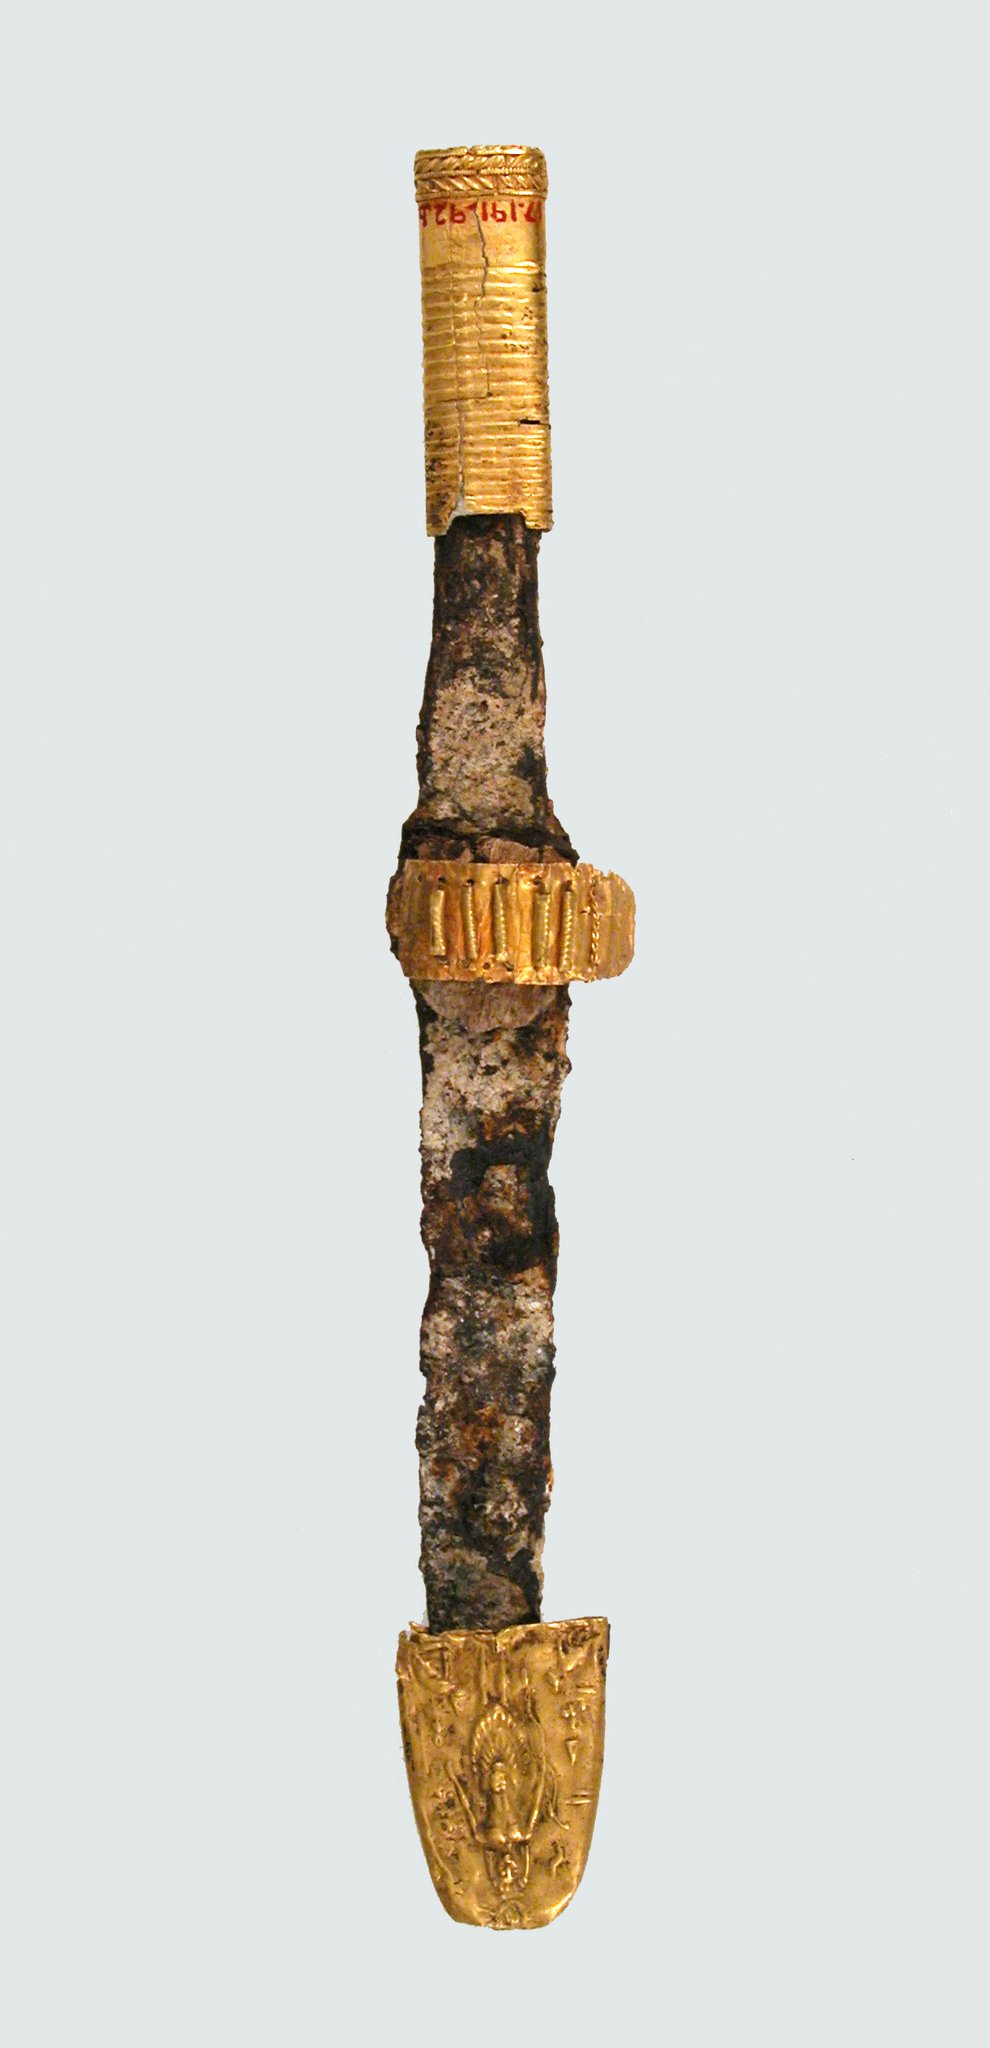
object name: knife handle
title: Mount from a Knife Handle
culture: frankish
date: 501-600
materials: gold, iron